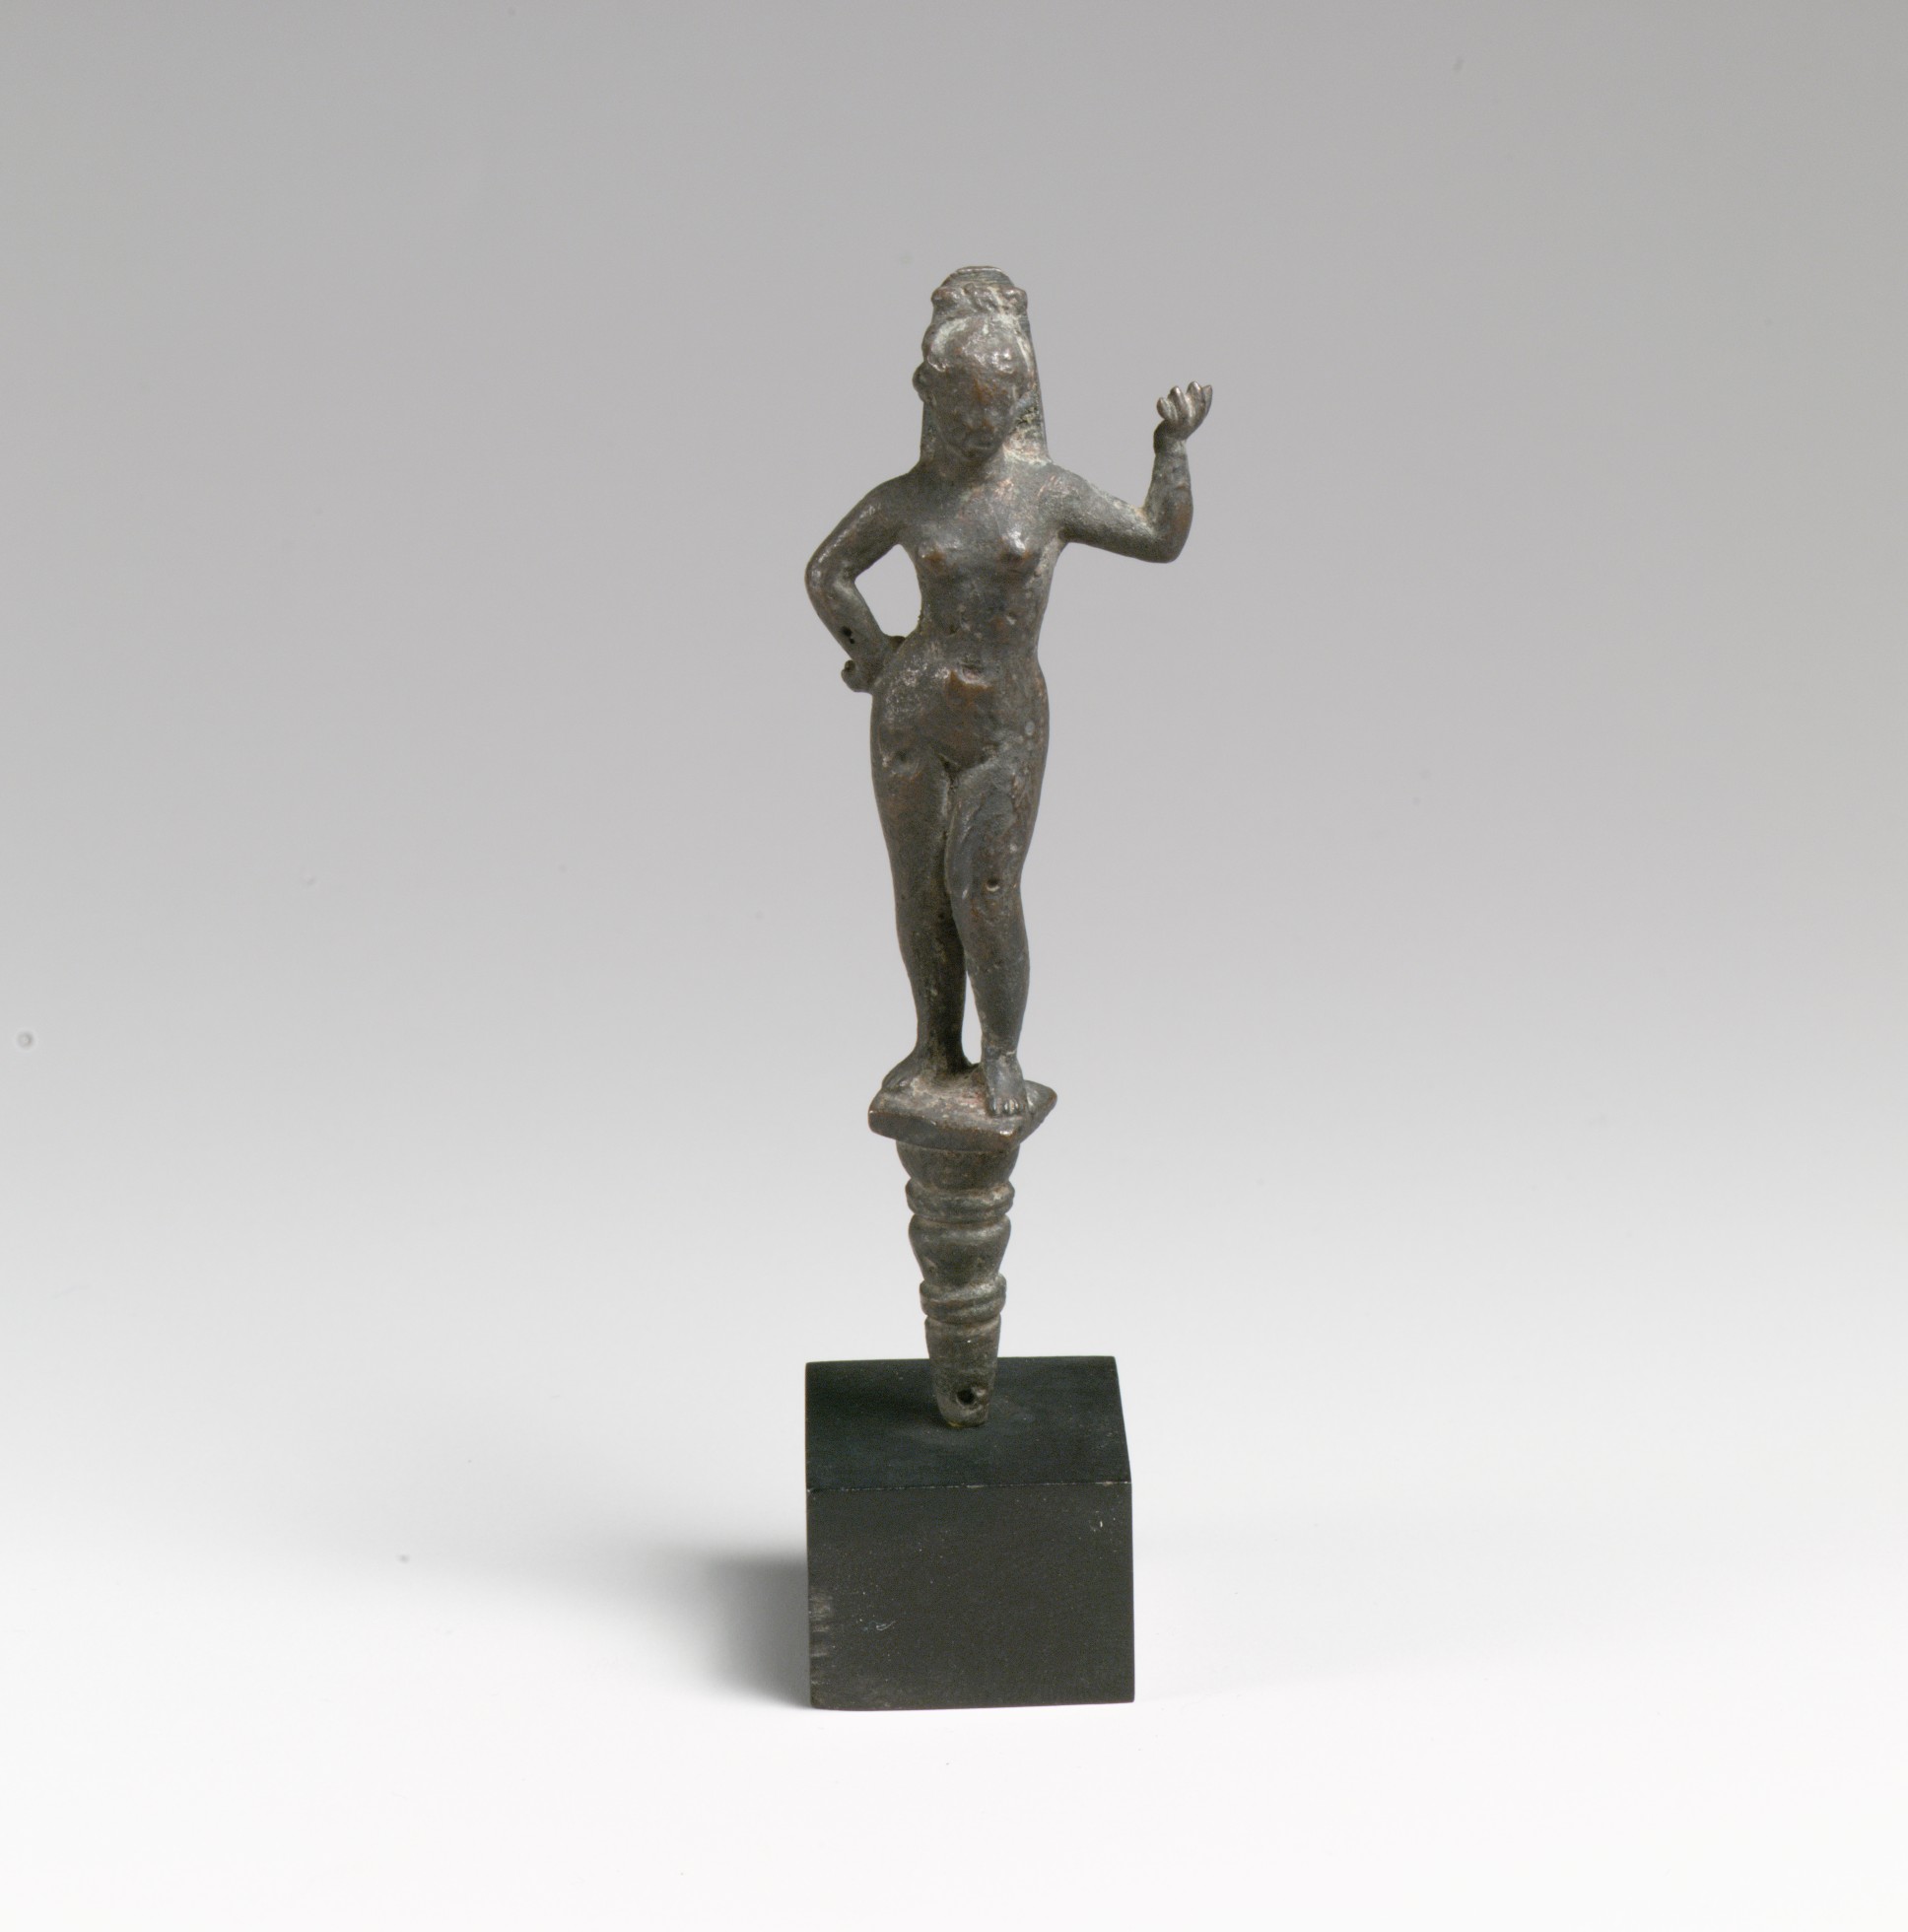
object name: mirror support with aphrodite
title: Bronze mirror handle (?) with Aphrodite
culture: roman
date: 1-200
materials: bronze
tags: aphrodite